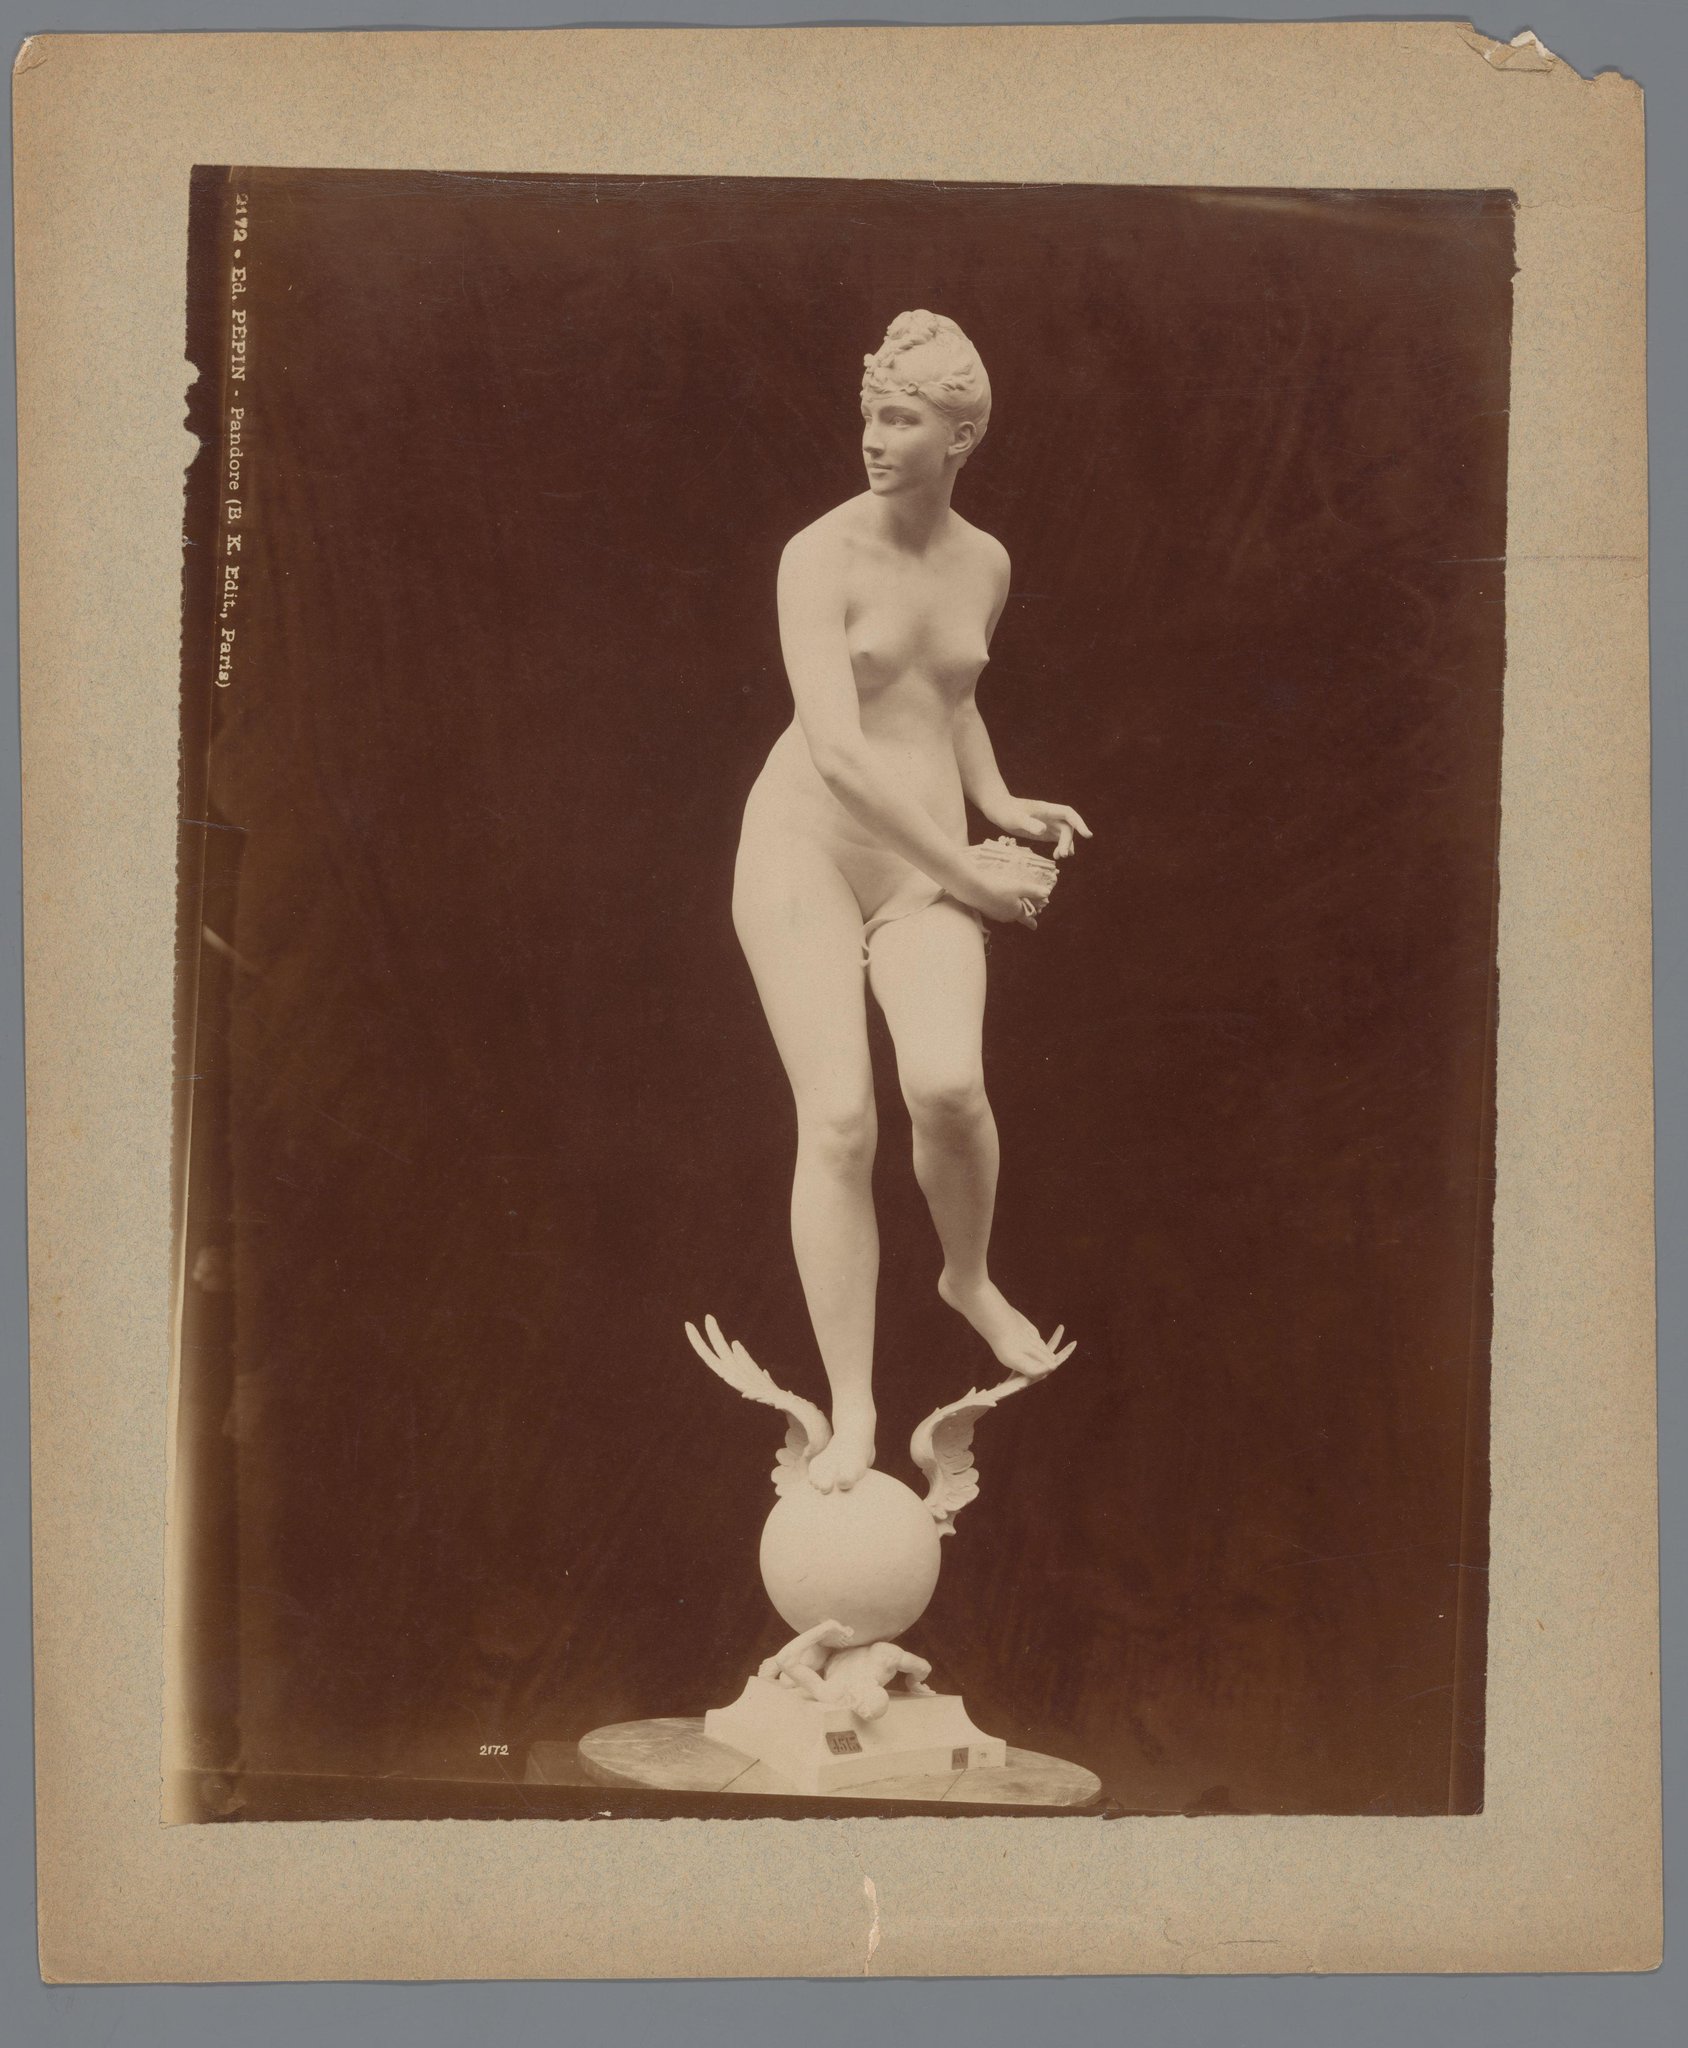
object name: photograph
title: Ed. PÉPIN - Pandore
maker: Anonymous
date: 1875-1900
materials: cardboard, photographic support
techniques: albumen print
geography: paris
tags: attributes of pandora: box, woman (showing herself) undressed, quasi-nude, (story of) pandora, sculpture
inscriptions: collector's mark: Lugt 3937, number: ‘2172’, inscription: ‘XI pl 9’